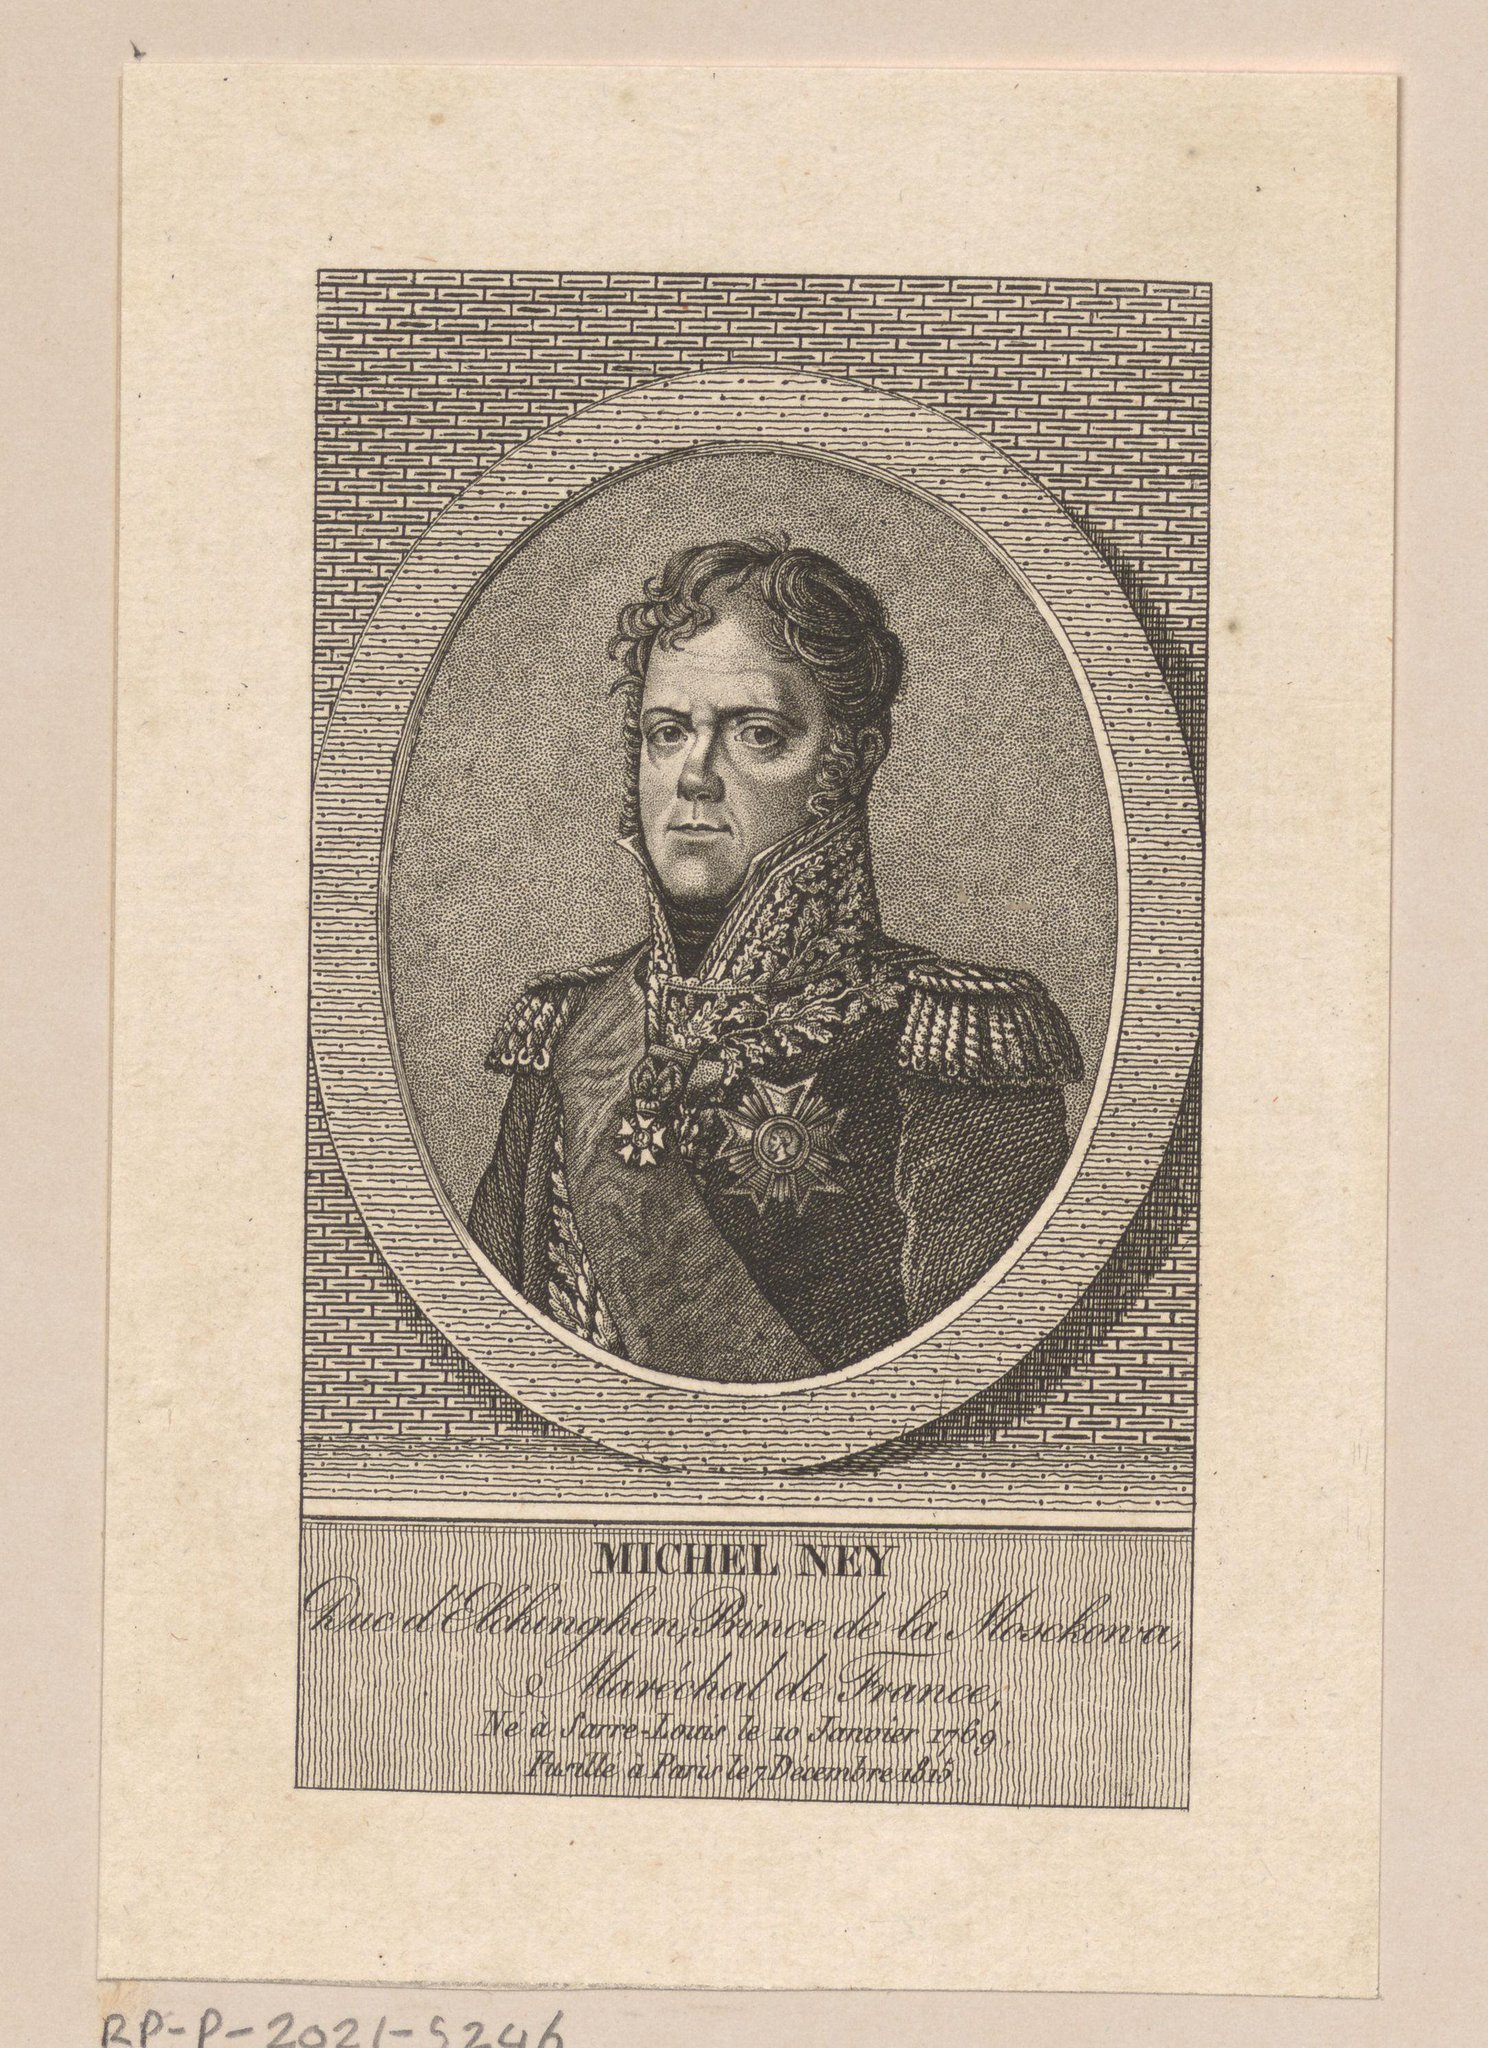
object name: print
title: Portret van Michel Ney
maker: Anonymous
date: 1815-1849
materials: paper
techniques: etching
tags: paris, commander-in-chief, general, marshal, historical persons